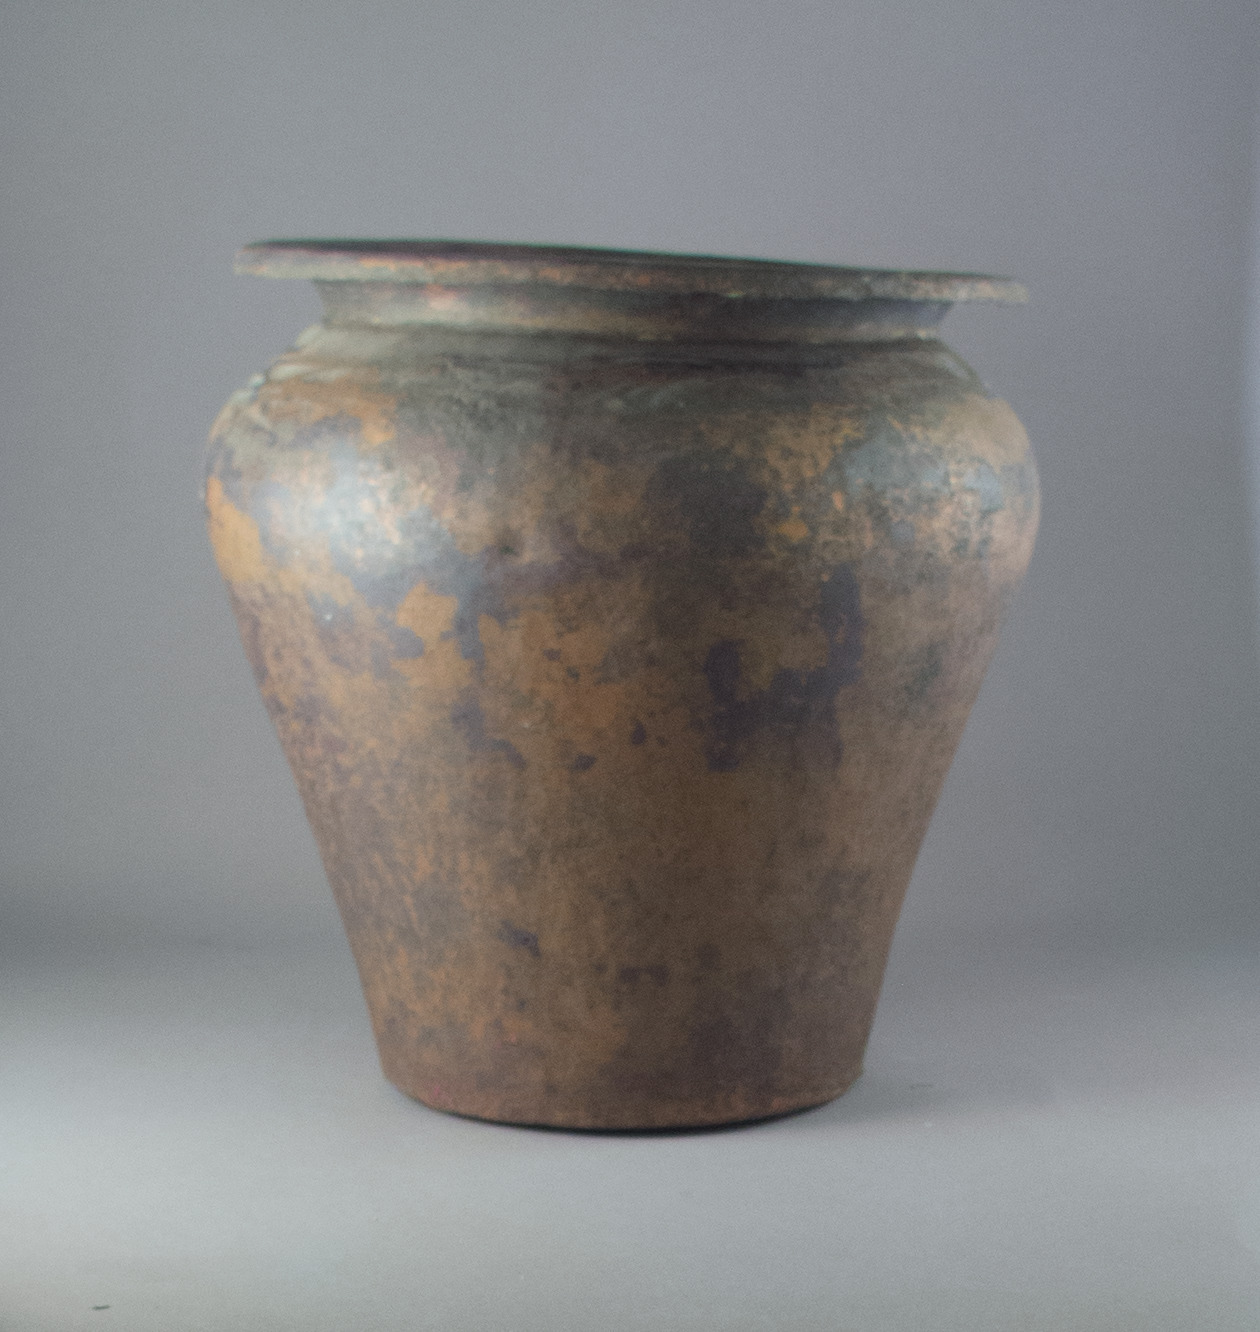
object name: situla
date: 7000 BCE-330 CE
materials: bronze